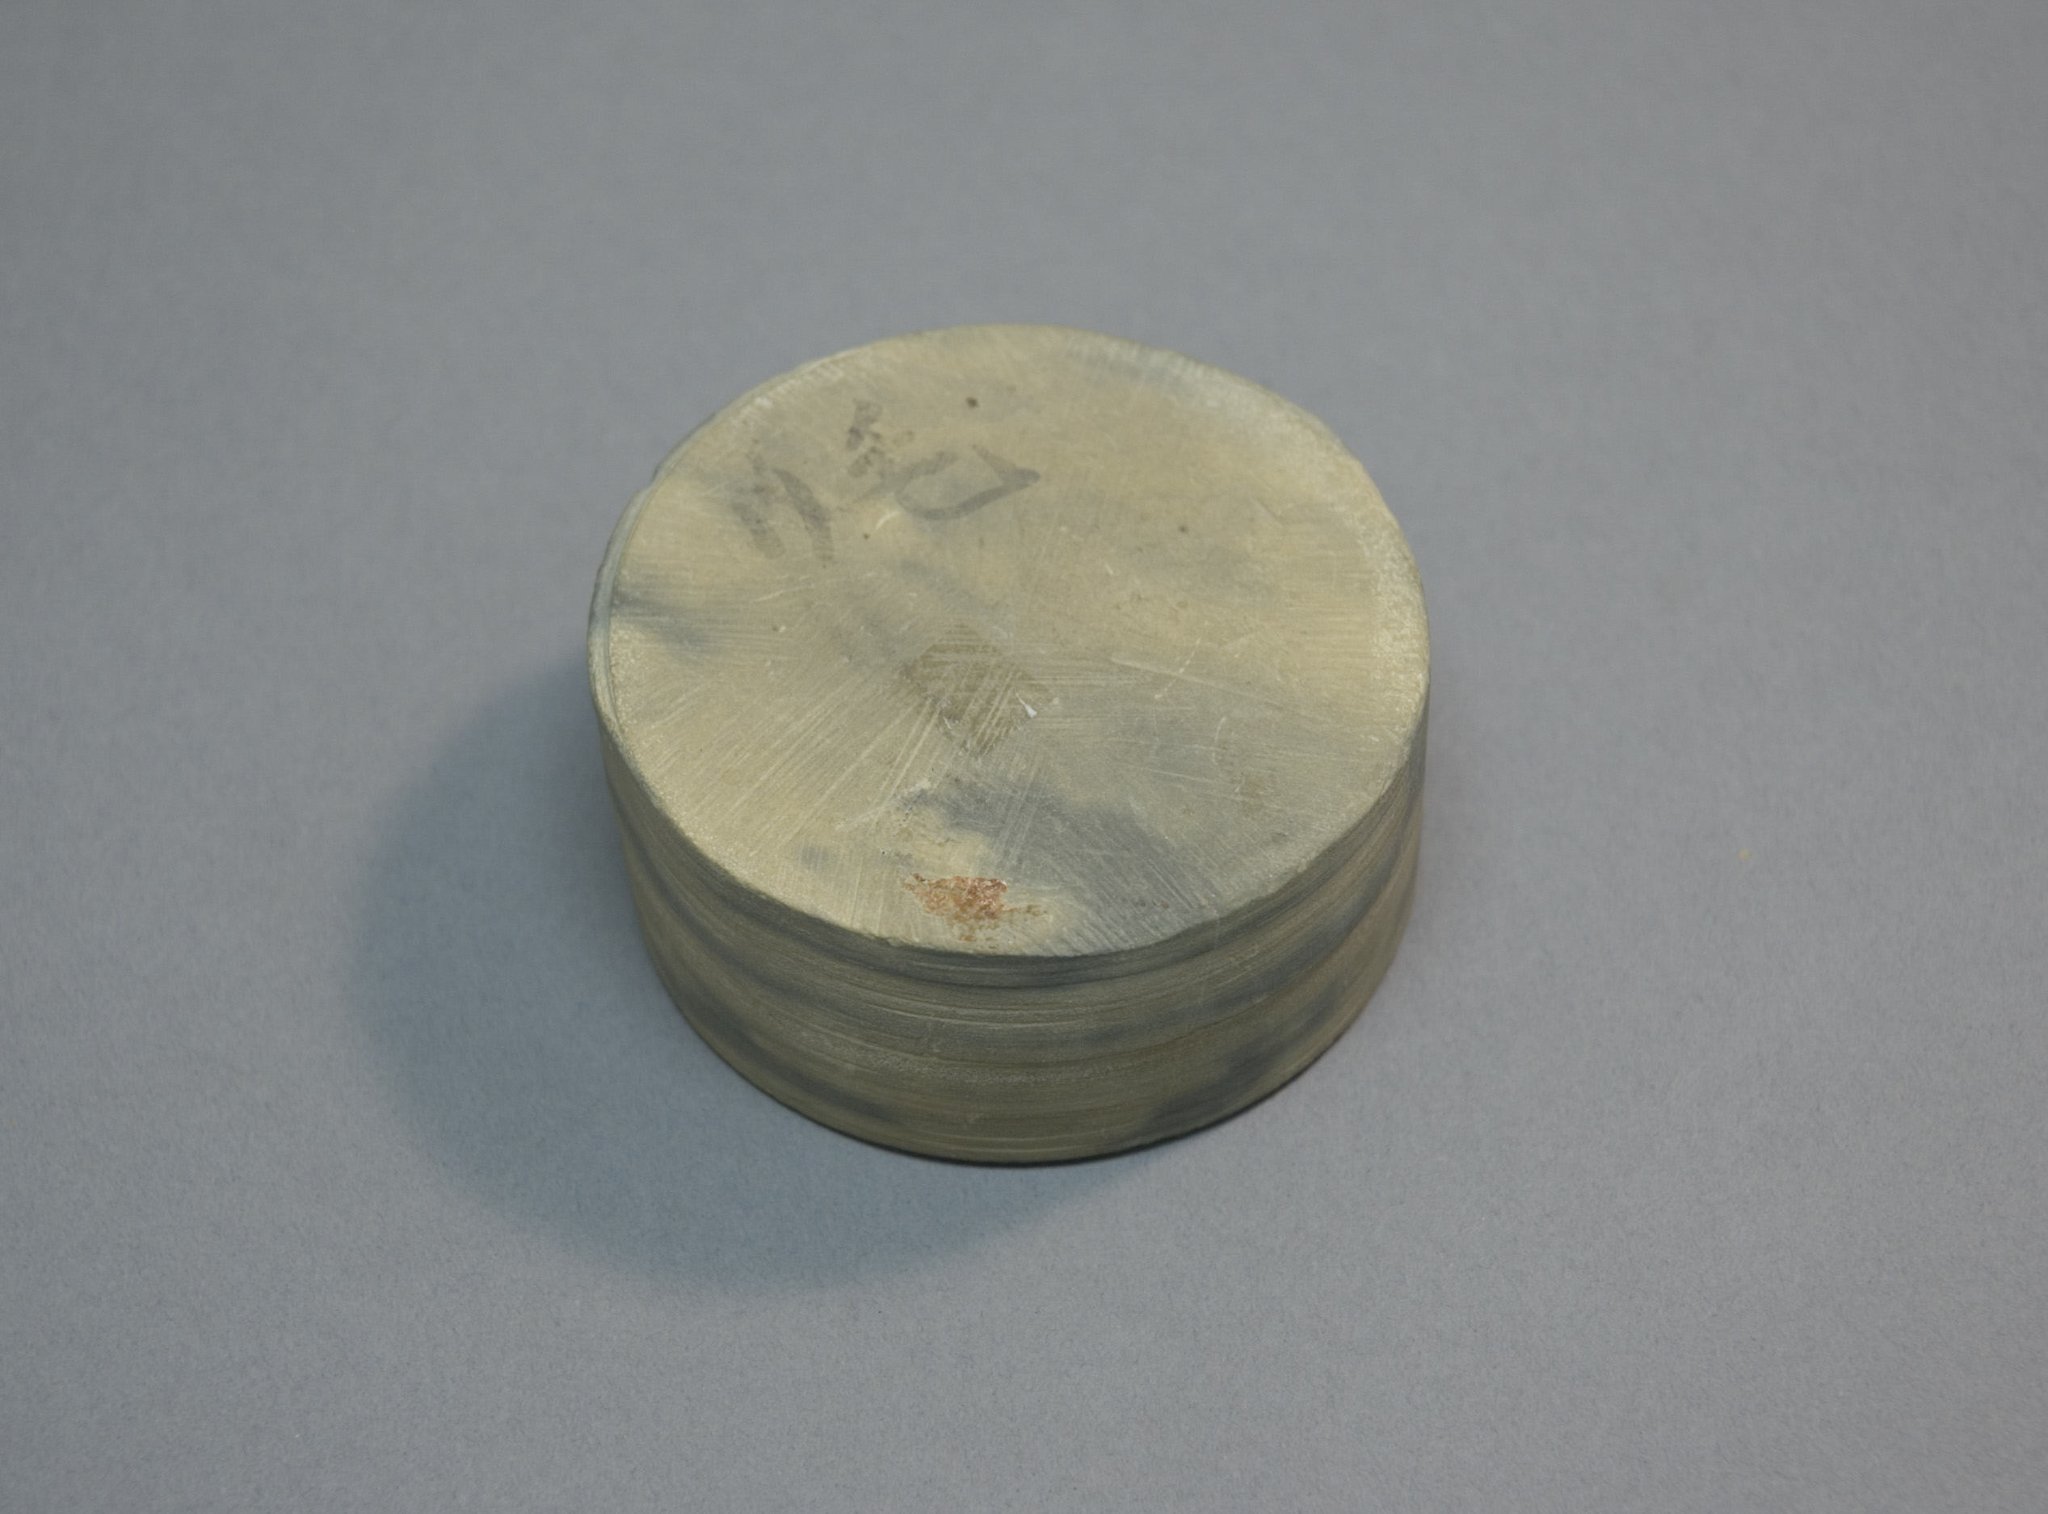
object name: jade carving tool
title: Polishing wheel for carving jade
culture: chinese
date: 1901-2000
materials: stone